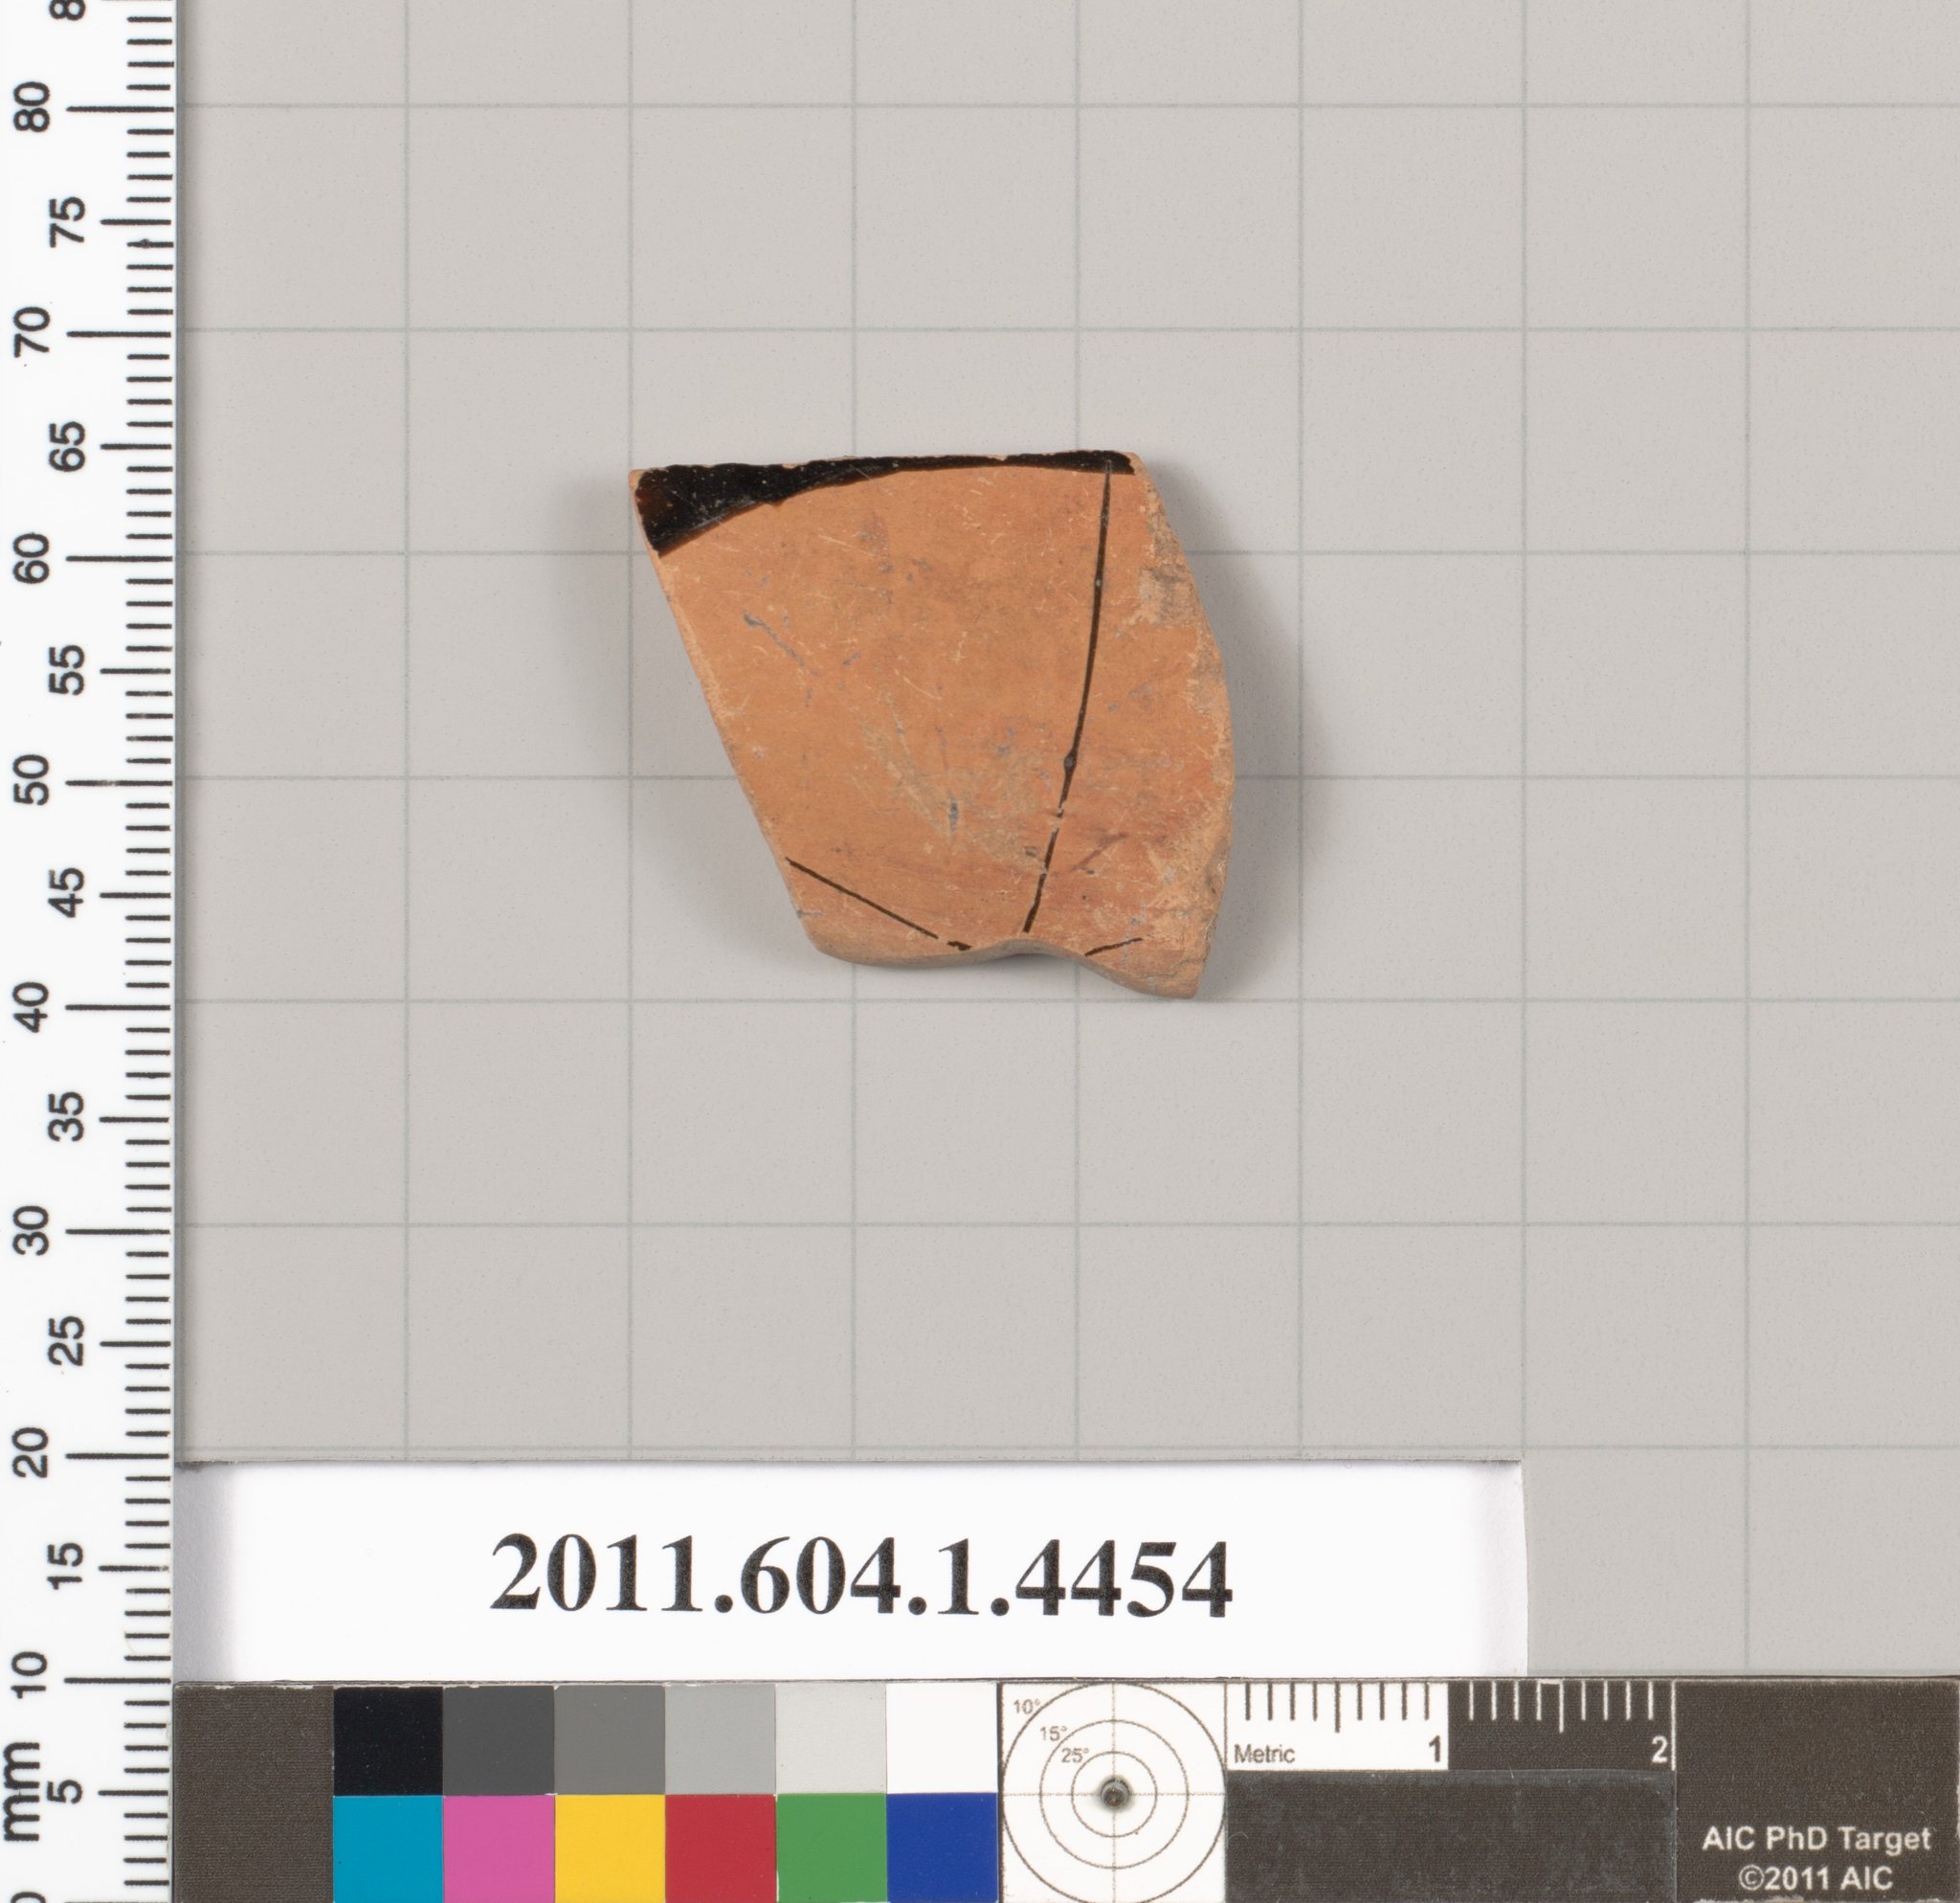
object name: kylix fragment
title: Terracotta fragment of a kylix (drinking cup)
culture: greek, attic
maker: penthesilean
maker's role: artist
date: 475-451 BCE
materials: terracotta